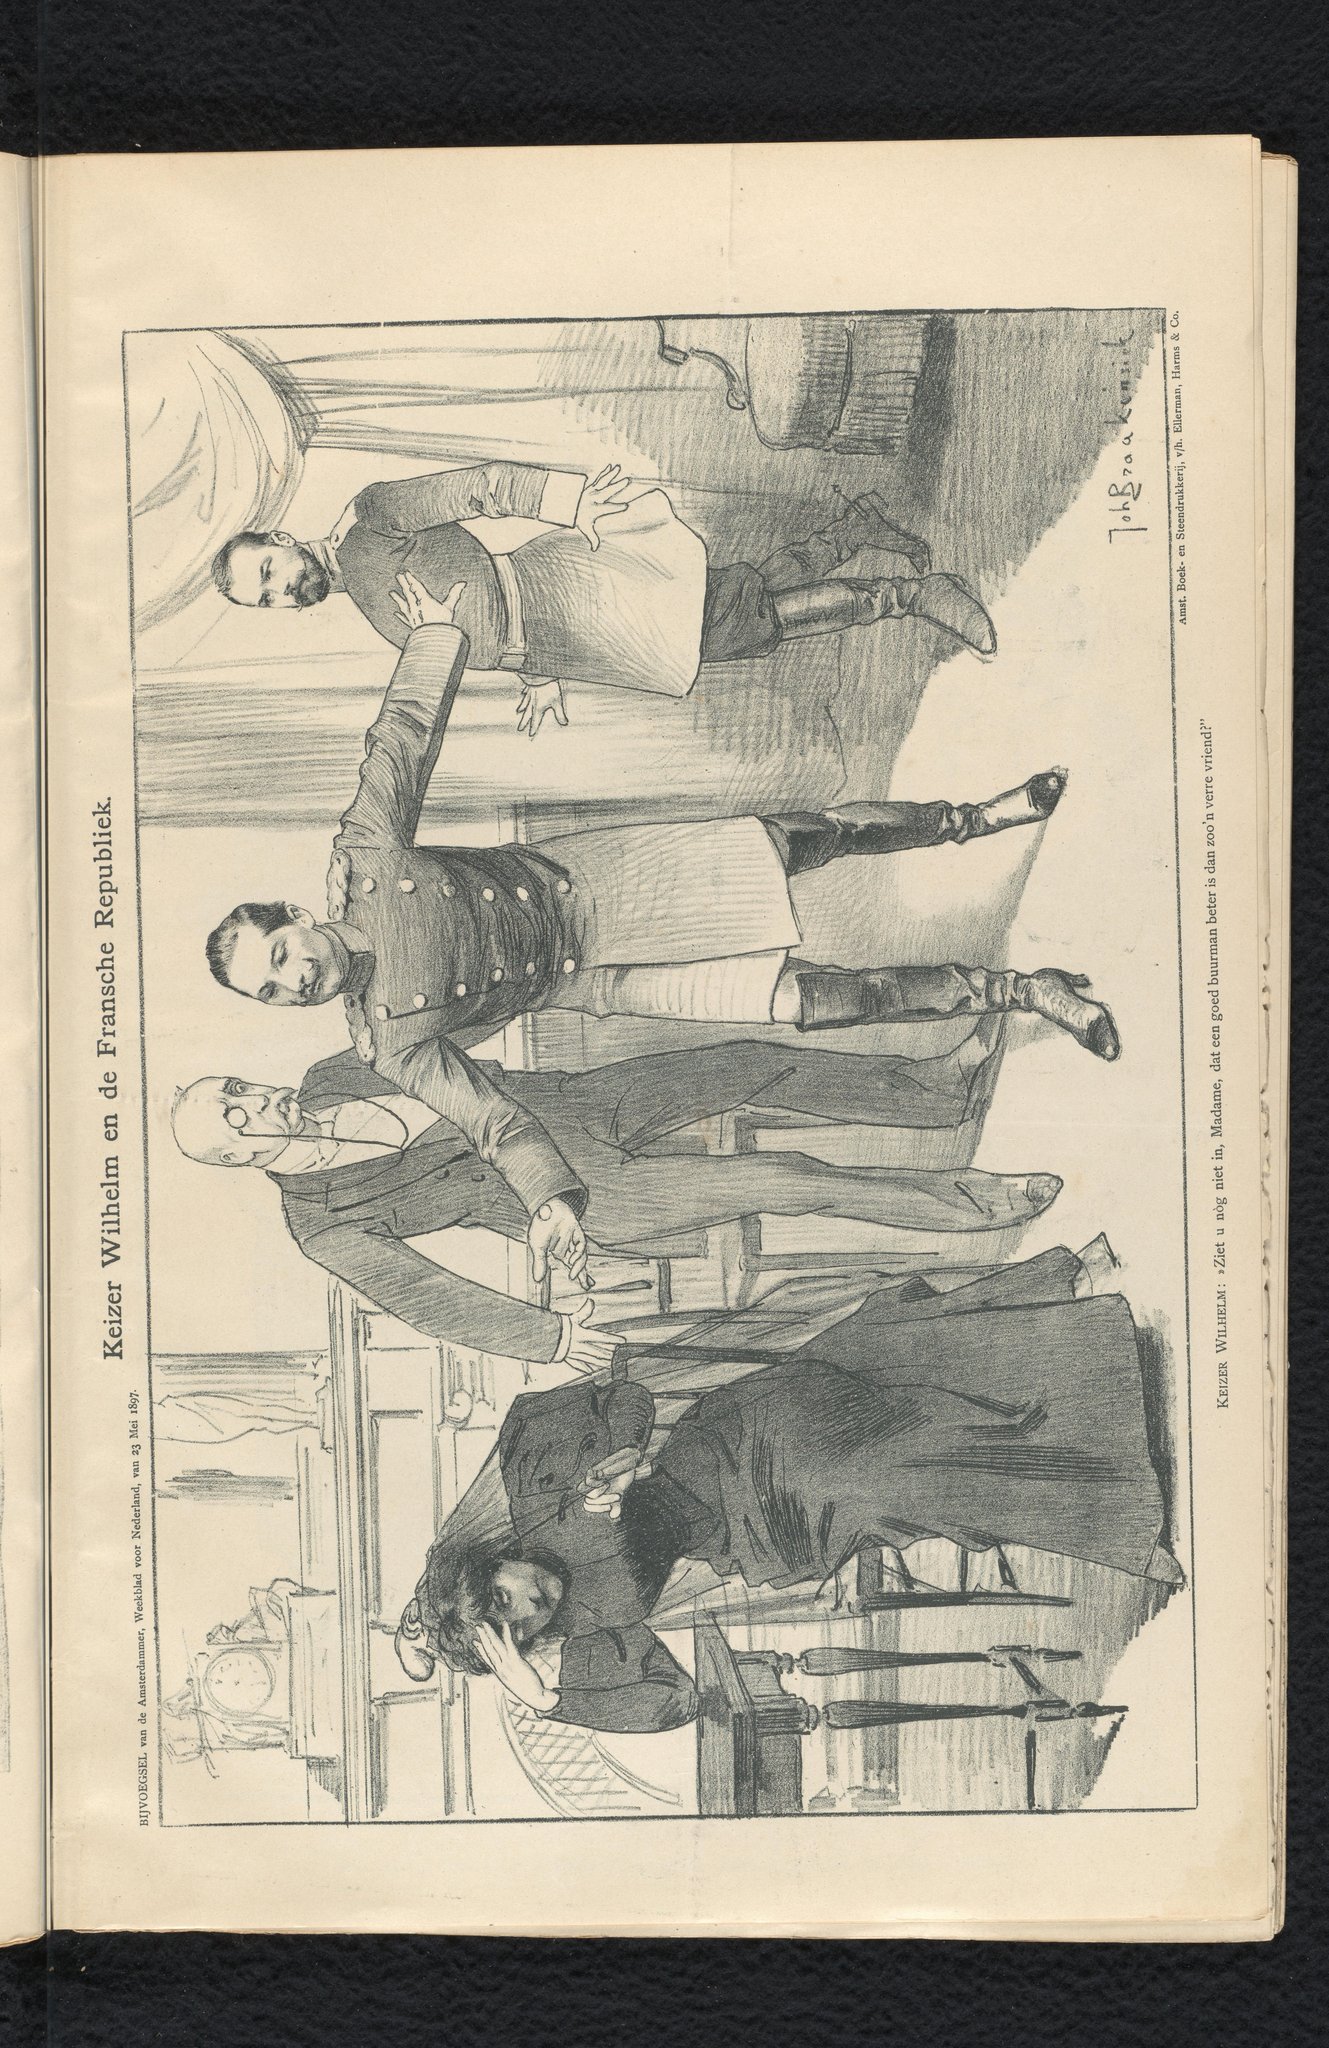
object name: cartoon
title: Keizer Wilhelm en de Fransche Republiek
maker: johan braakensiek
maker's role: draughtsman, print maker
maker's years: 1858-1940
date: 1897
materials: paper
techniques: lithograph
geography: amsterdam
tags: wilhelm ii (keizer van duitsland), political caricatures and satires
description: Keizer Wilhelm II werpt zich op als goede buur voor Frankrijk en houdt Rusland (tsaar Nicolaas II) op een afstand.